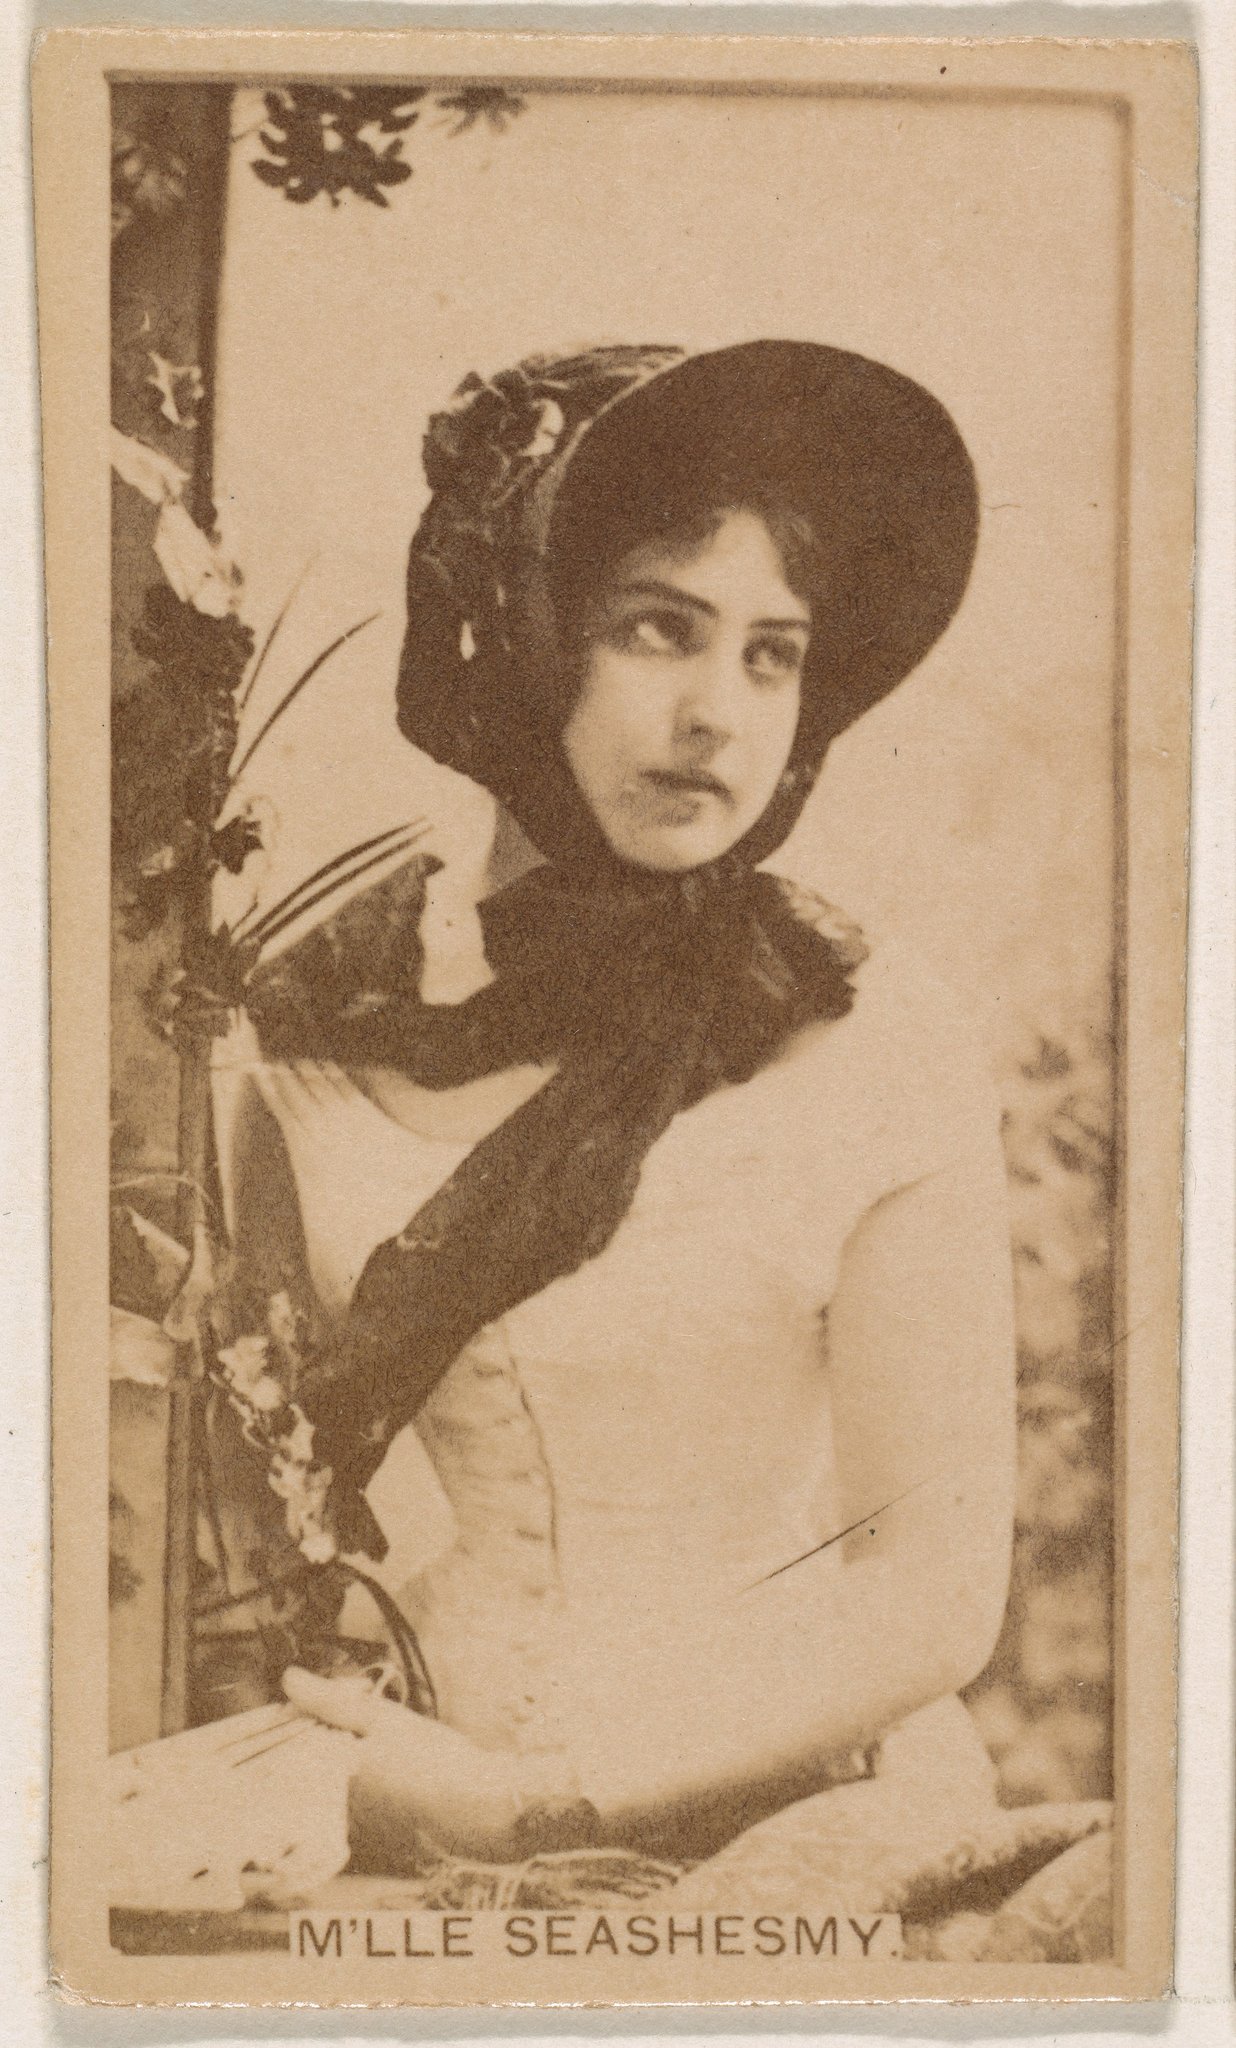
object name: photograph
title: M'lle Seashesmy, from the Actresses series (N245) issued by Kinney Brothers to promote Sweet Caporal Cigarettes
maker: kinney brothers tobacco company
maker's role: publisher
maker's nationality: american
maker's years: 1869-2011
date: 1890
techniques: albumen silver print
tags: portraits,women,actresses